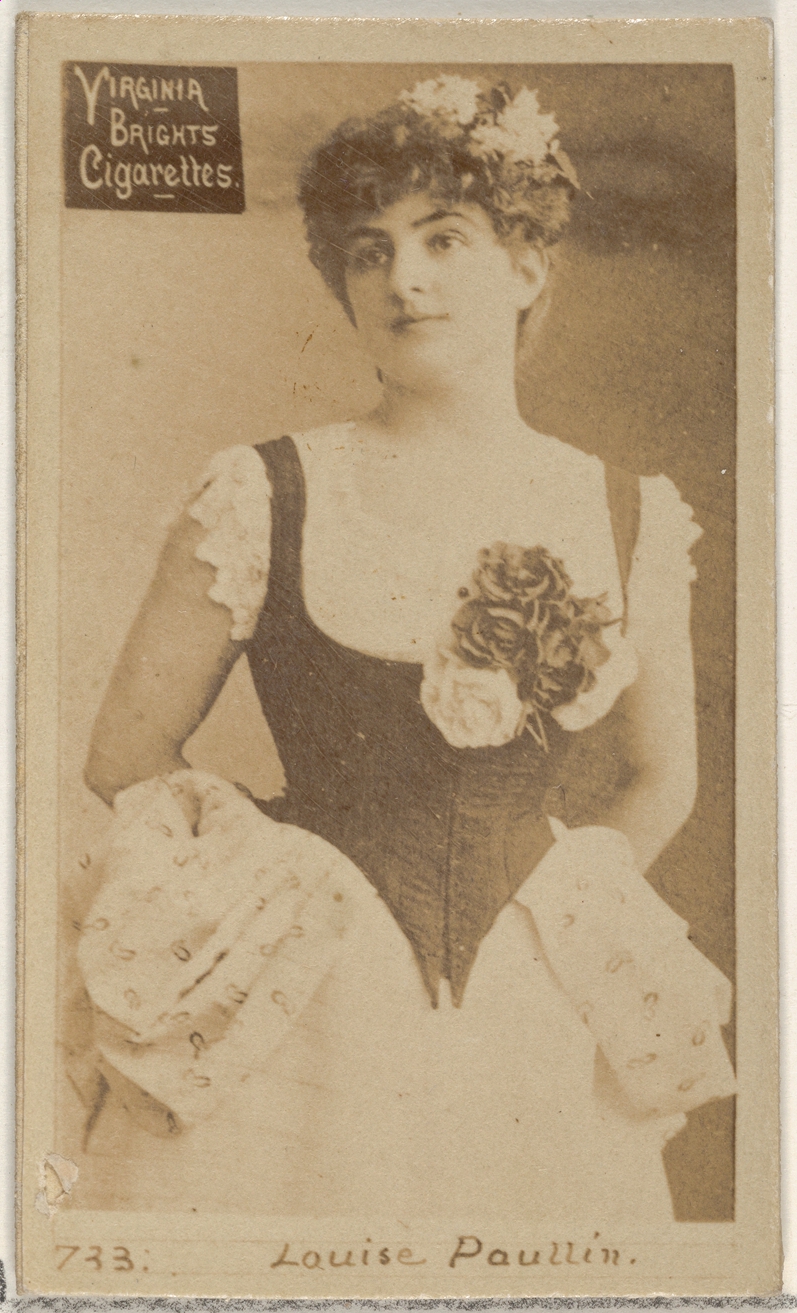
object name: photograph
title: Card 733, Louise Paullin, from the Actors and Actresses series (N45, Type 2) for Virginia Brights Cigarettes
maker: allen & ginter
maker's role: publisher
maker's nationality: american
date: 1888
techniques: albumen silver print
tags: portraits,women,actresses